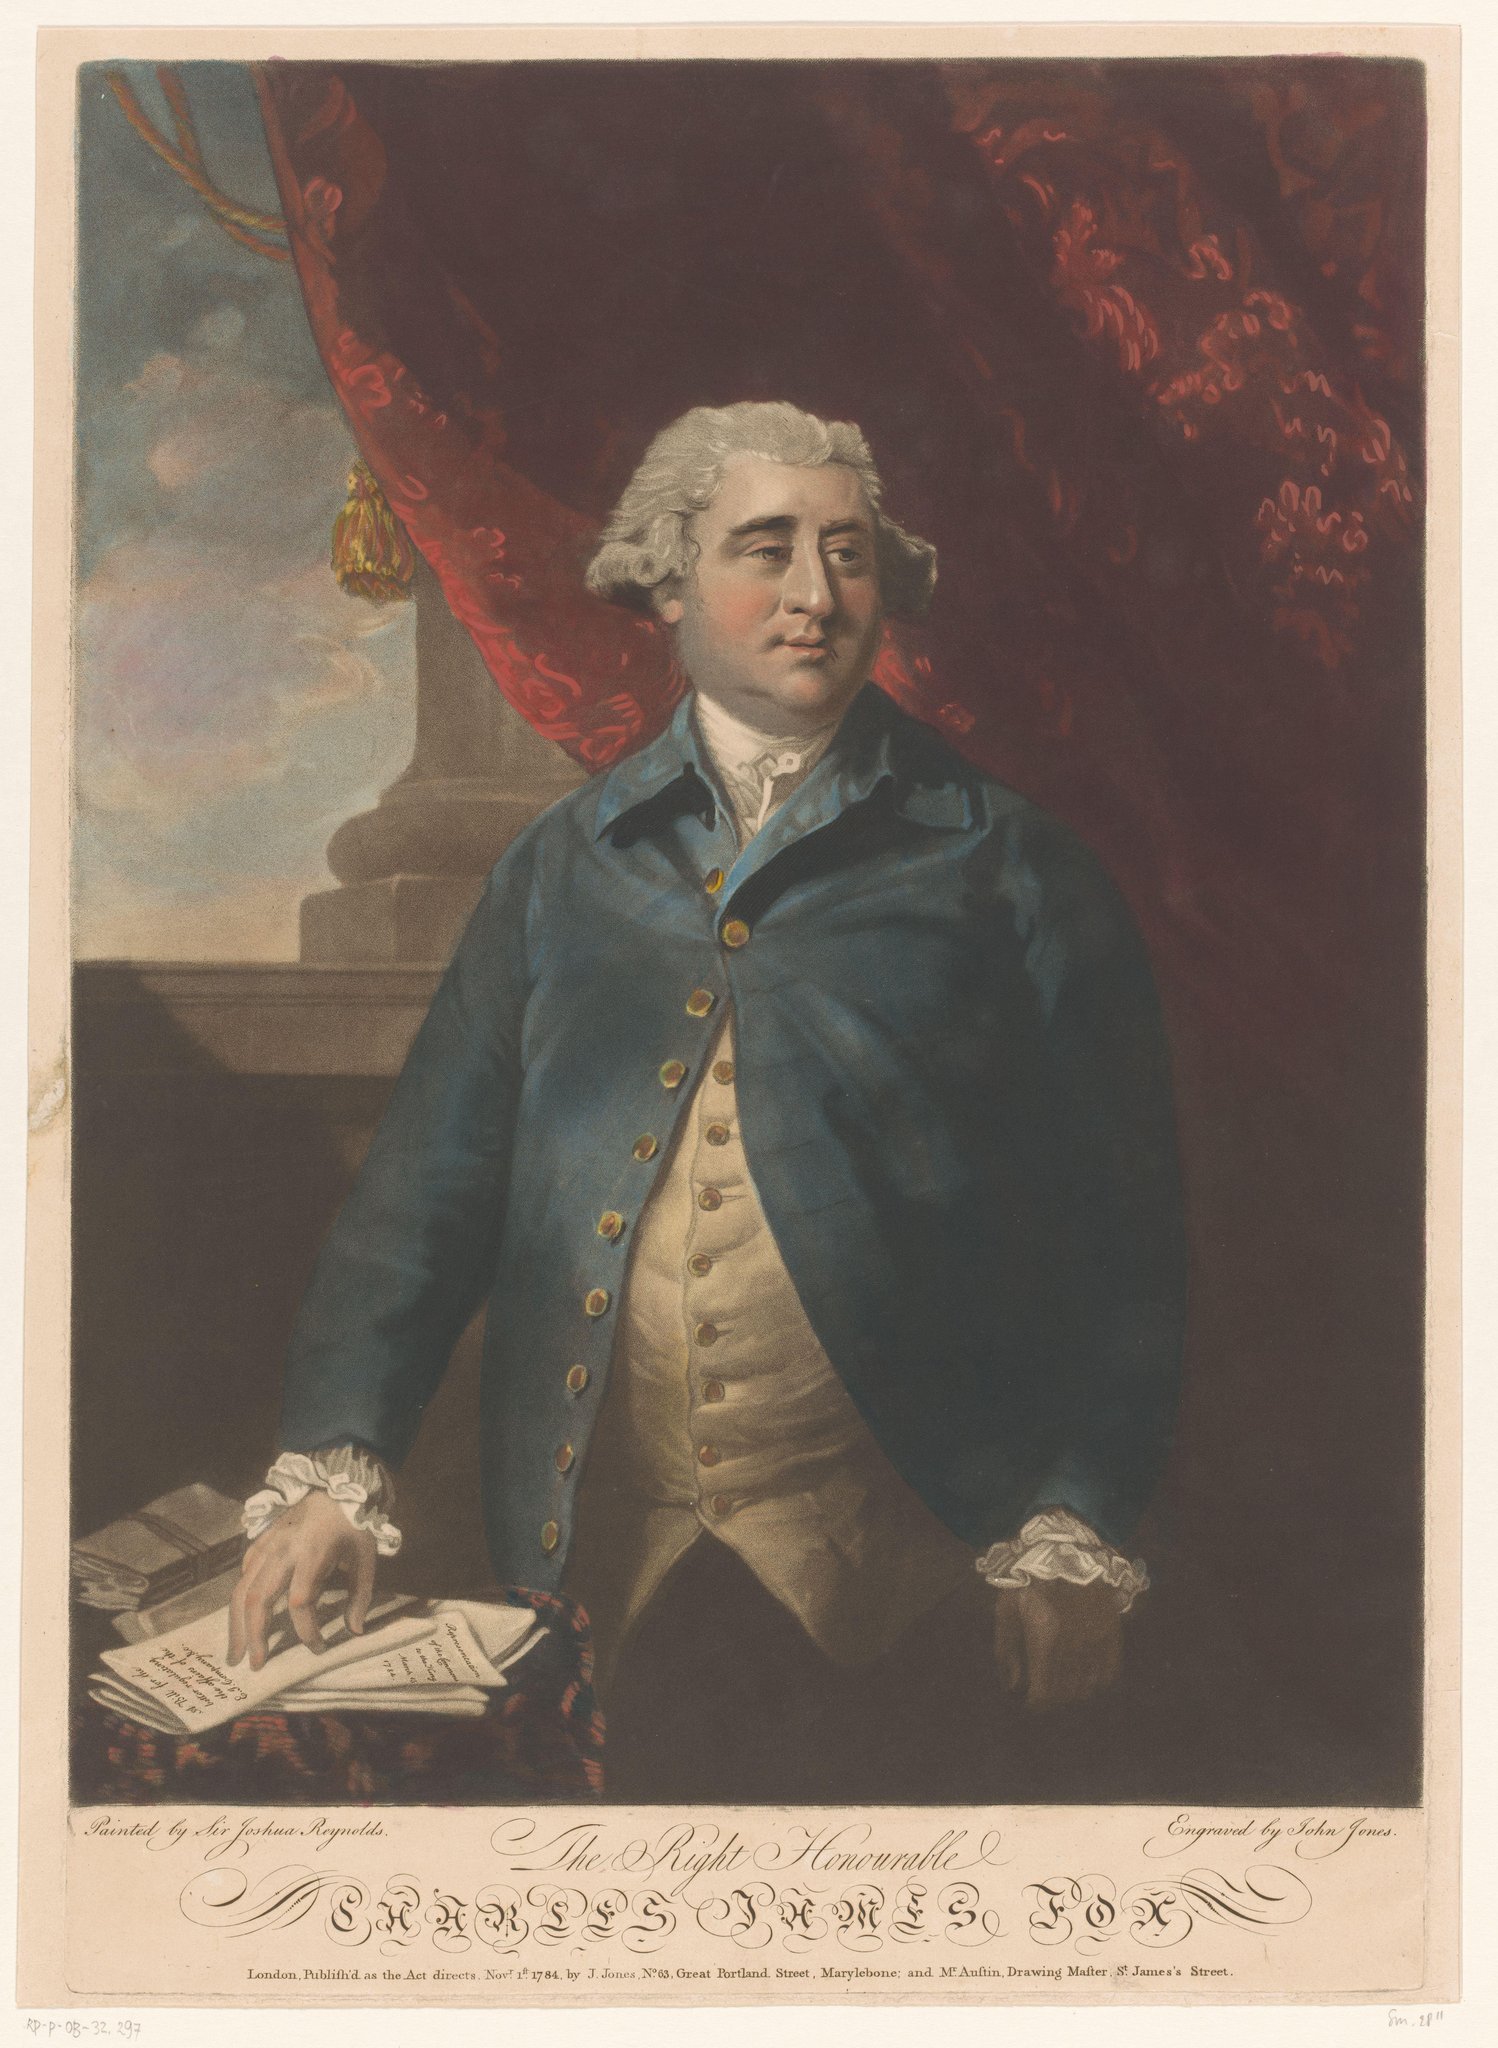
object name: print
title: Portret van Charles James Fox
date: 1784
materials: paint, paper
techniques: brush, hand coloring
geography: london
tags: london, historical persons, politician, e.g. party leader